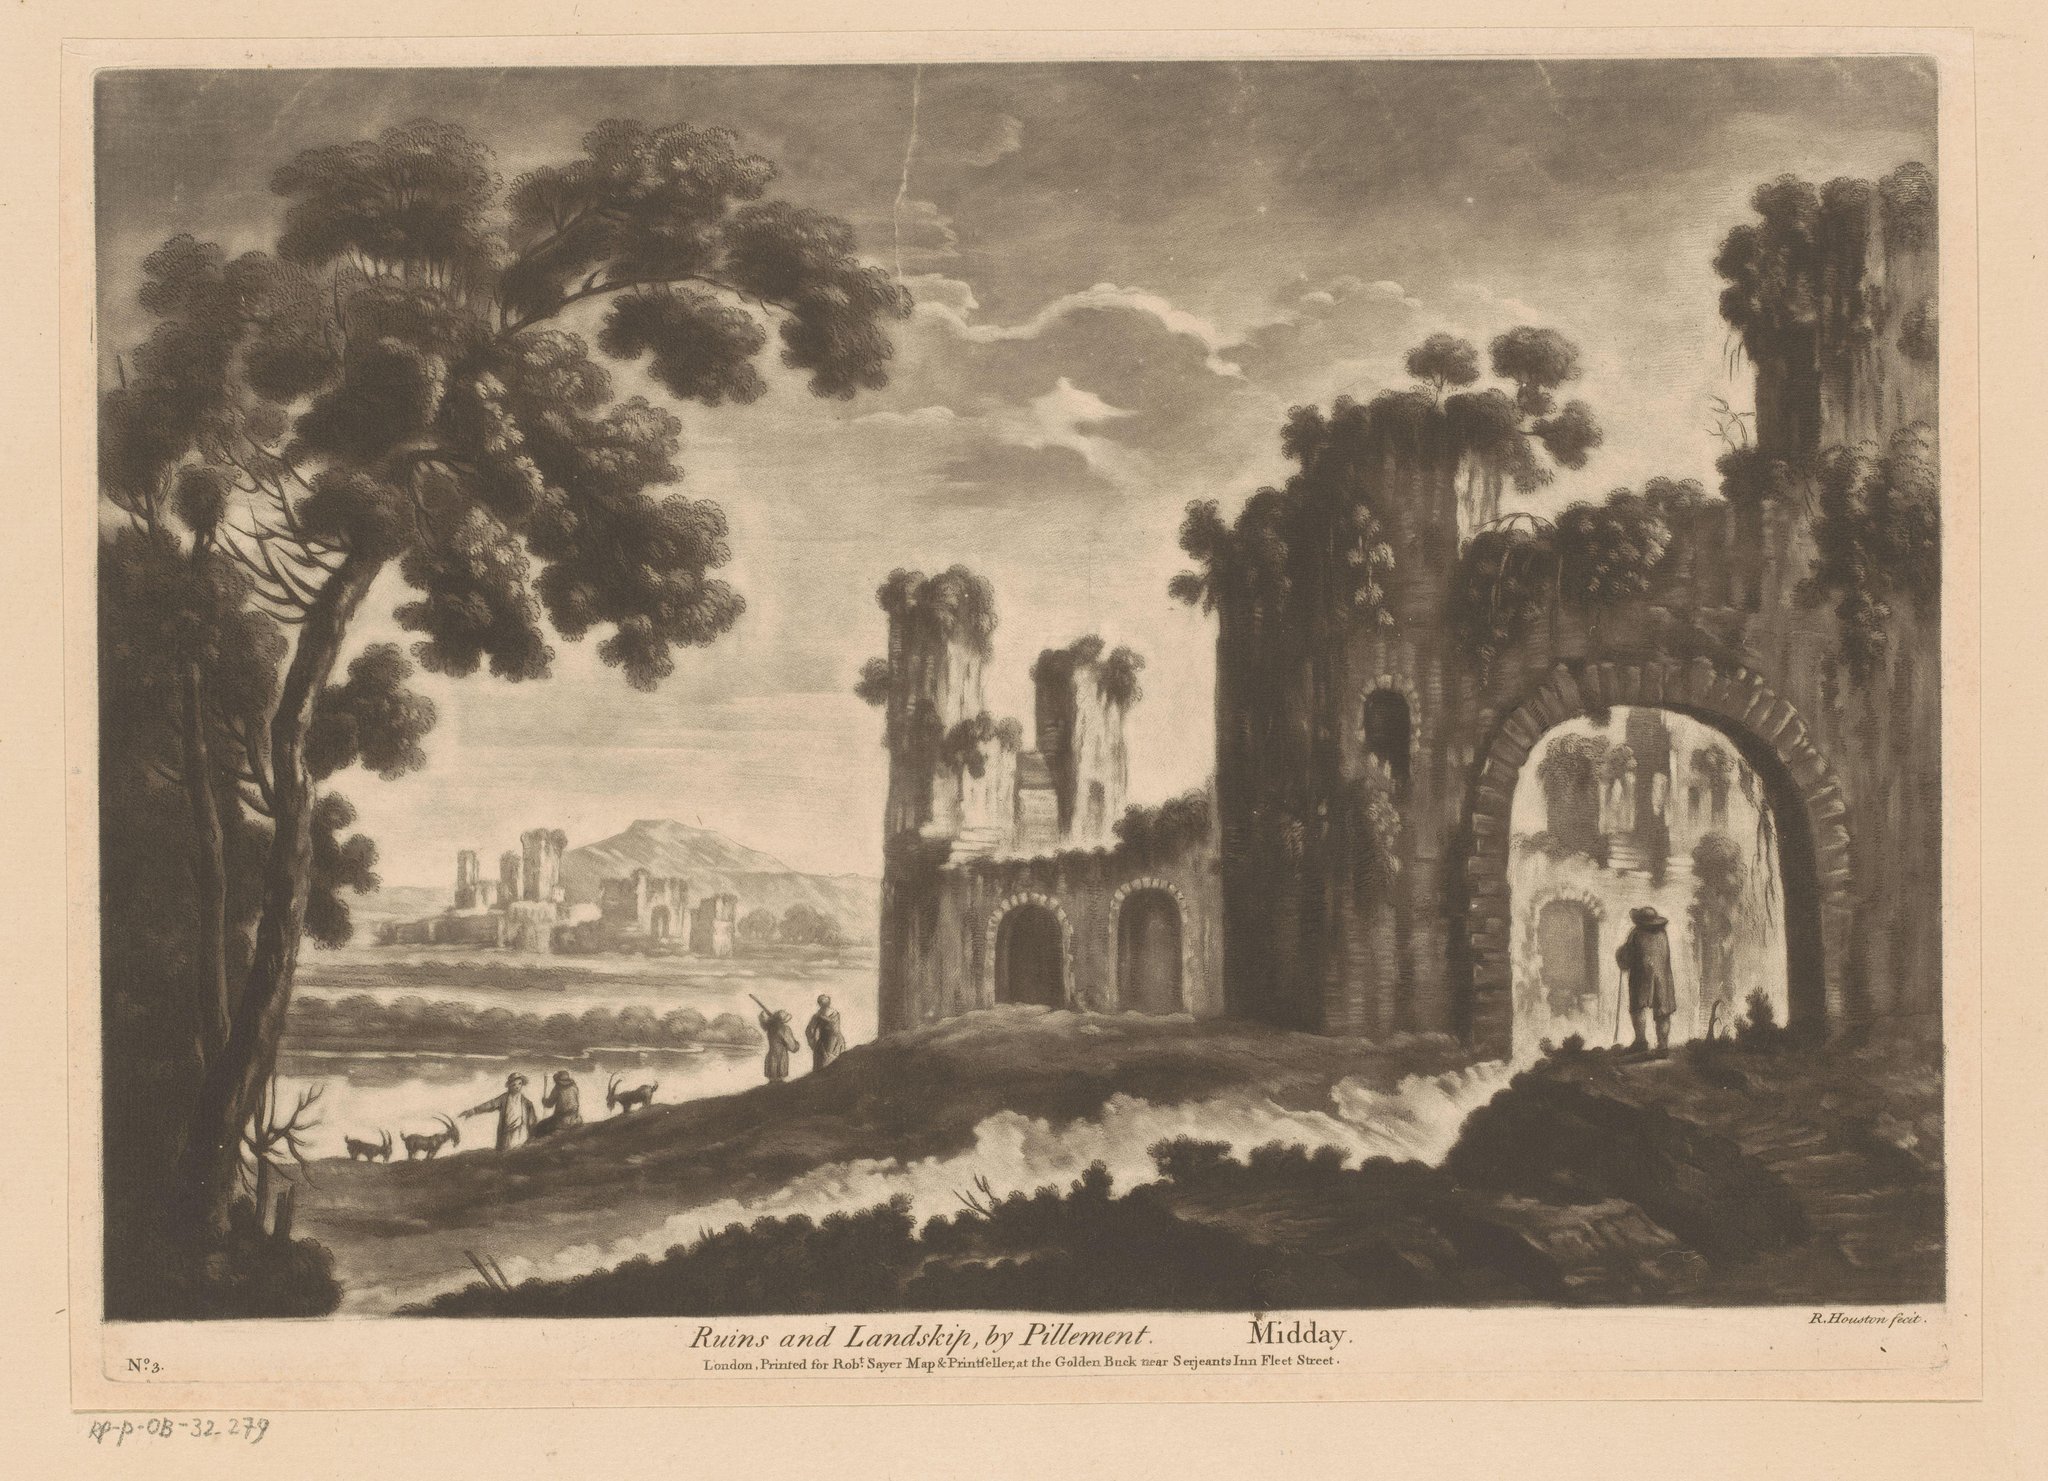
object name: print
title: Midday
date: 1745-1794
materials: paper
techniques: etching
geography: london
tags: low hill country (+ landscape with figures, staffage), landscape with ruins (+ city(-scape) with figures, staffage), fisherman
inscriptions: collector's mark: Lugt 240